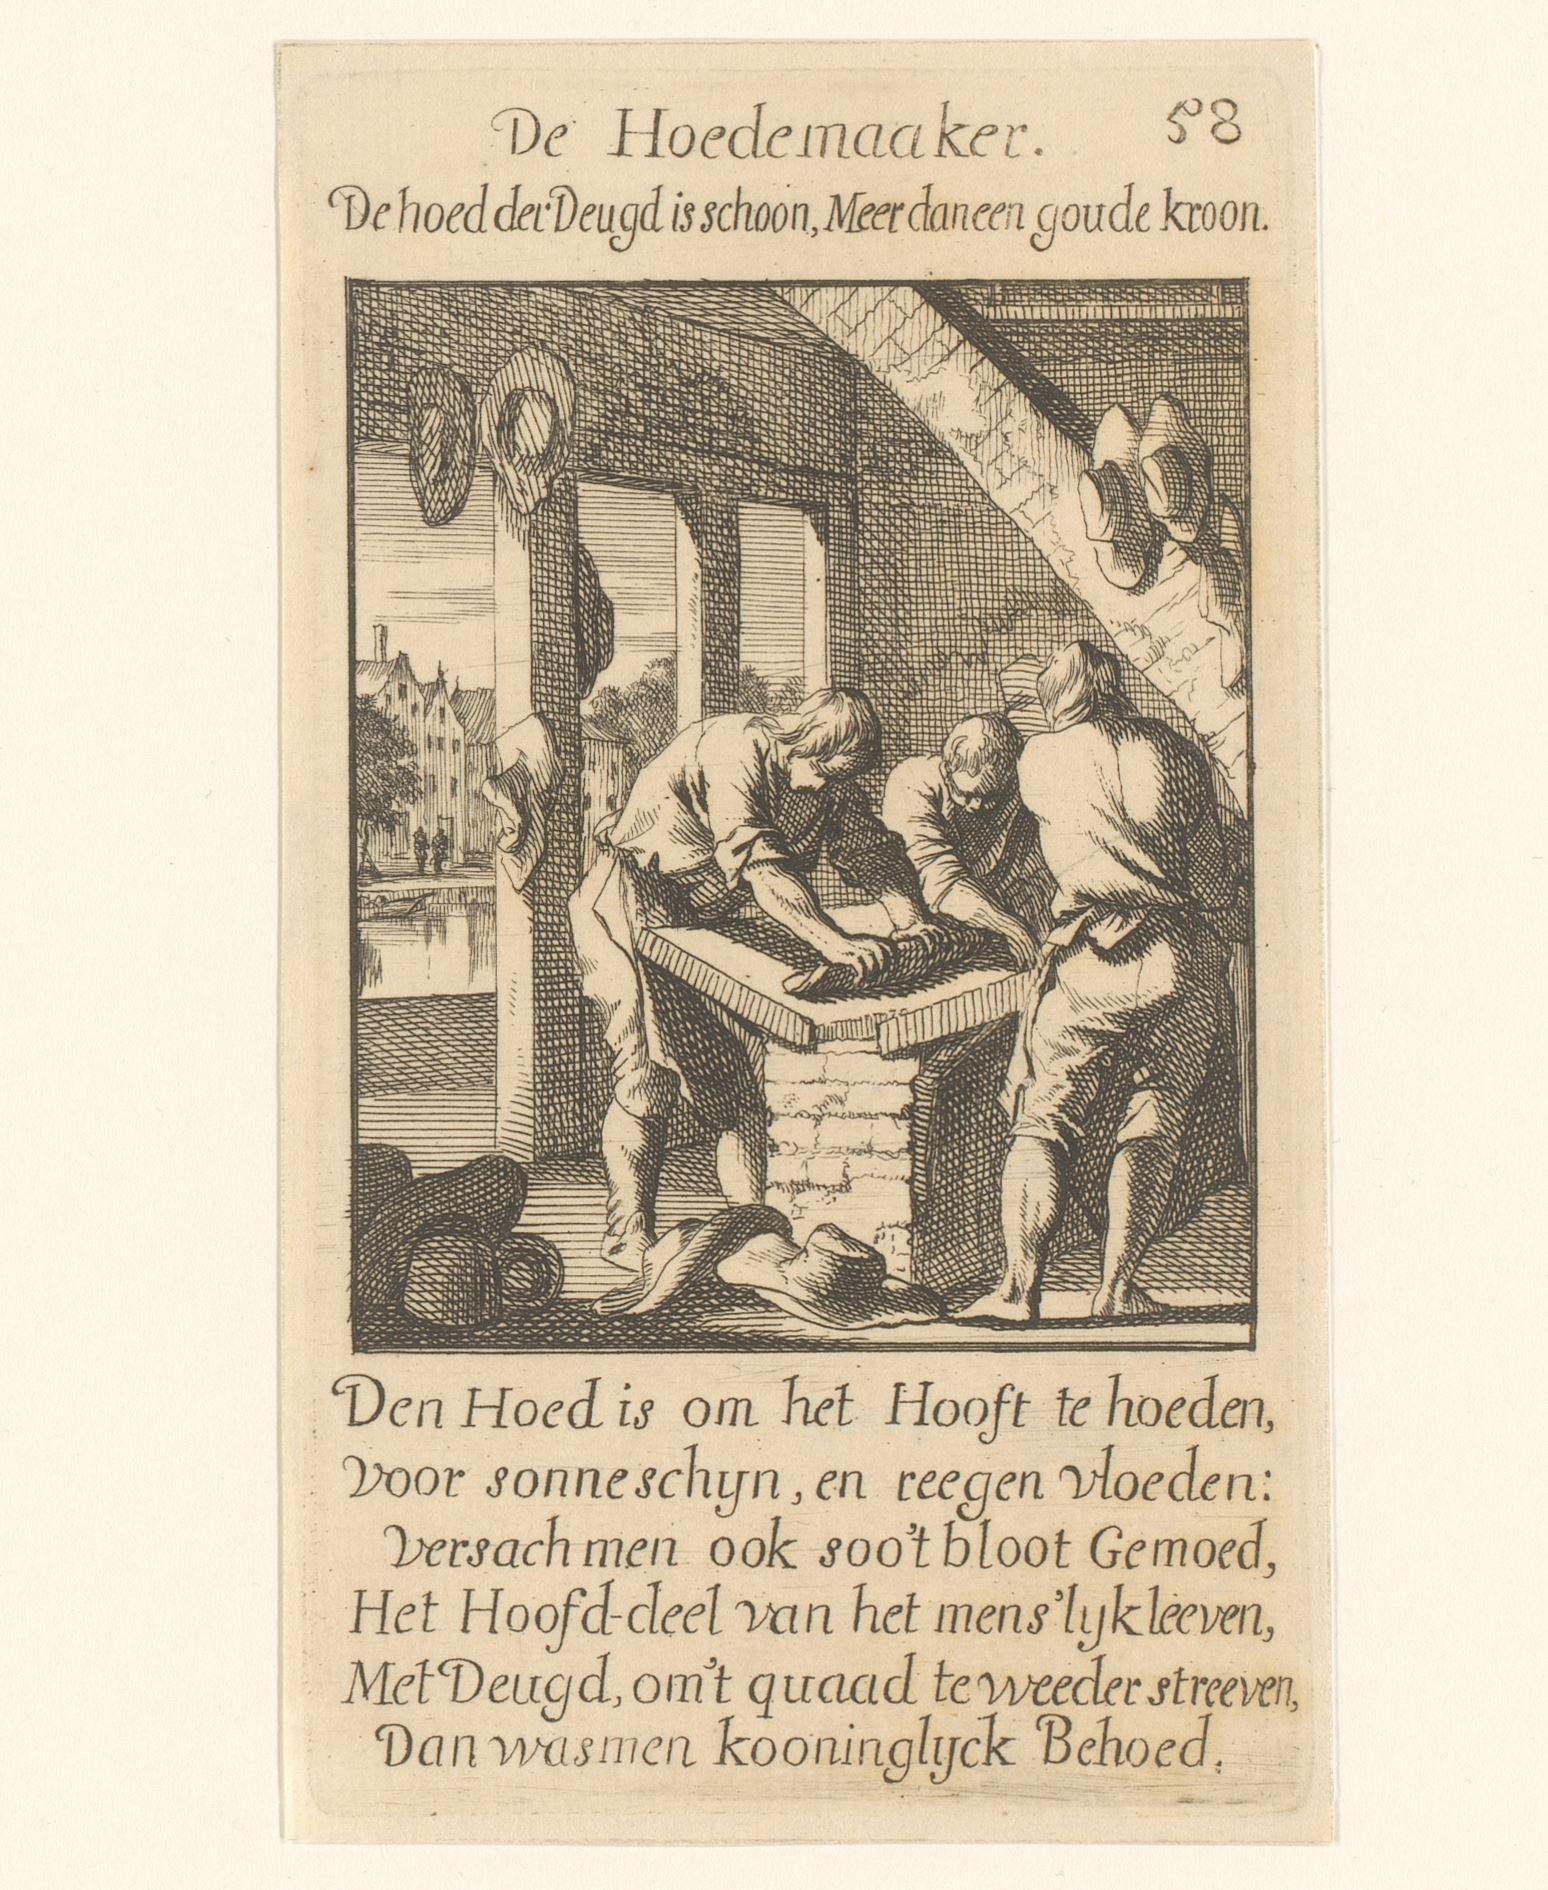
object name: print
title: Ambachten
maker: jan luyken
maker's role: draughtsman, print maker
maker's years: 1649-1712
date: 1694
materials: paper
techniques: etching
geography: amsterdam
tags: handicrafts, craftsman at work, hatter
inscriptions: collector's mark: Lugt 2228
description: Rechtsboven genummerd: 58. Met zesregelig vers in het Nederlands.